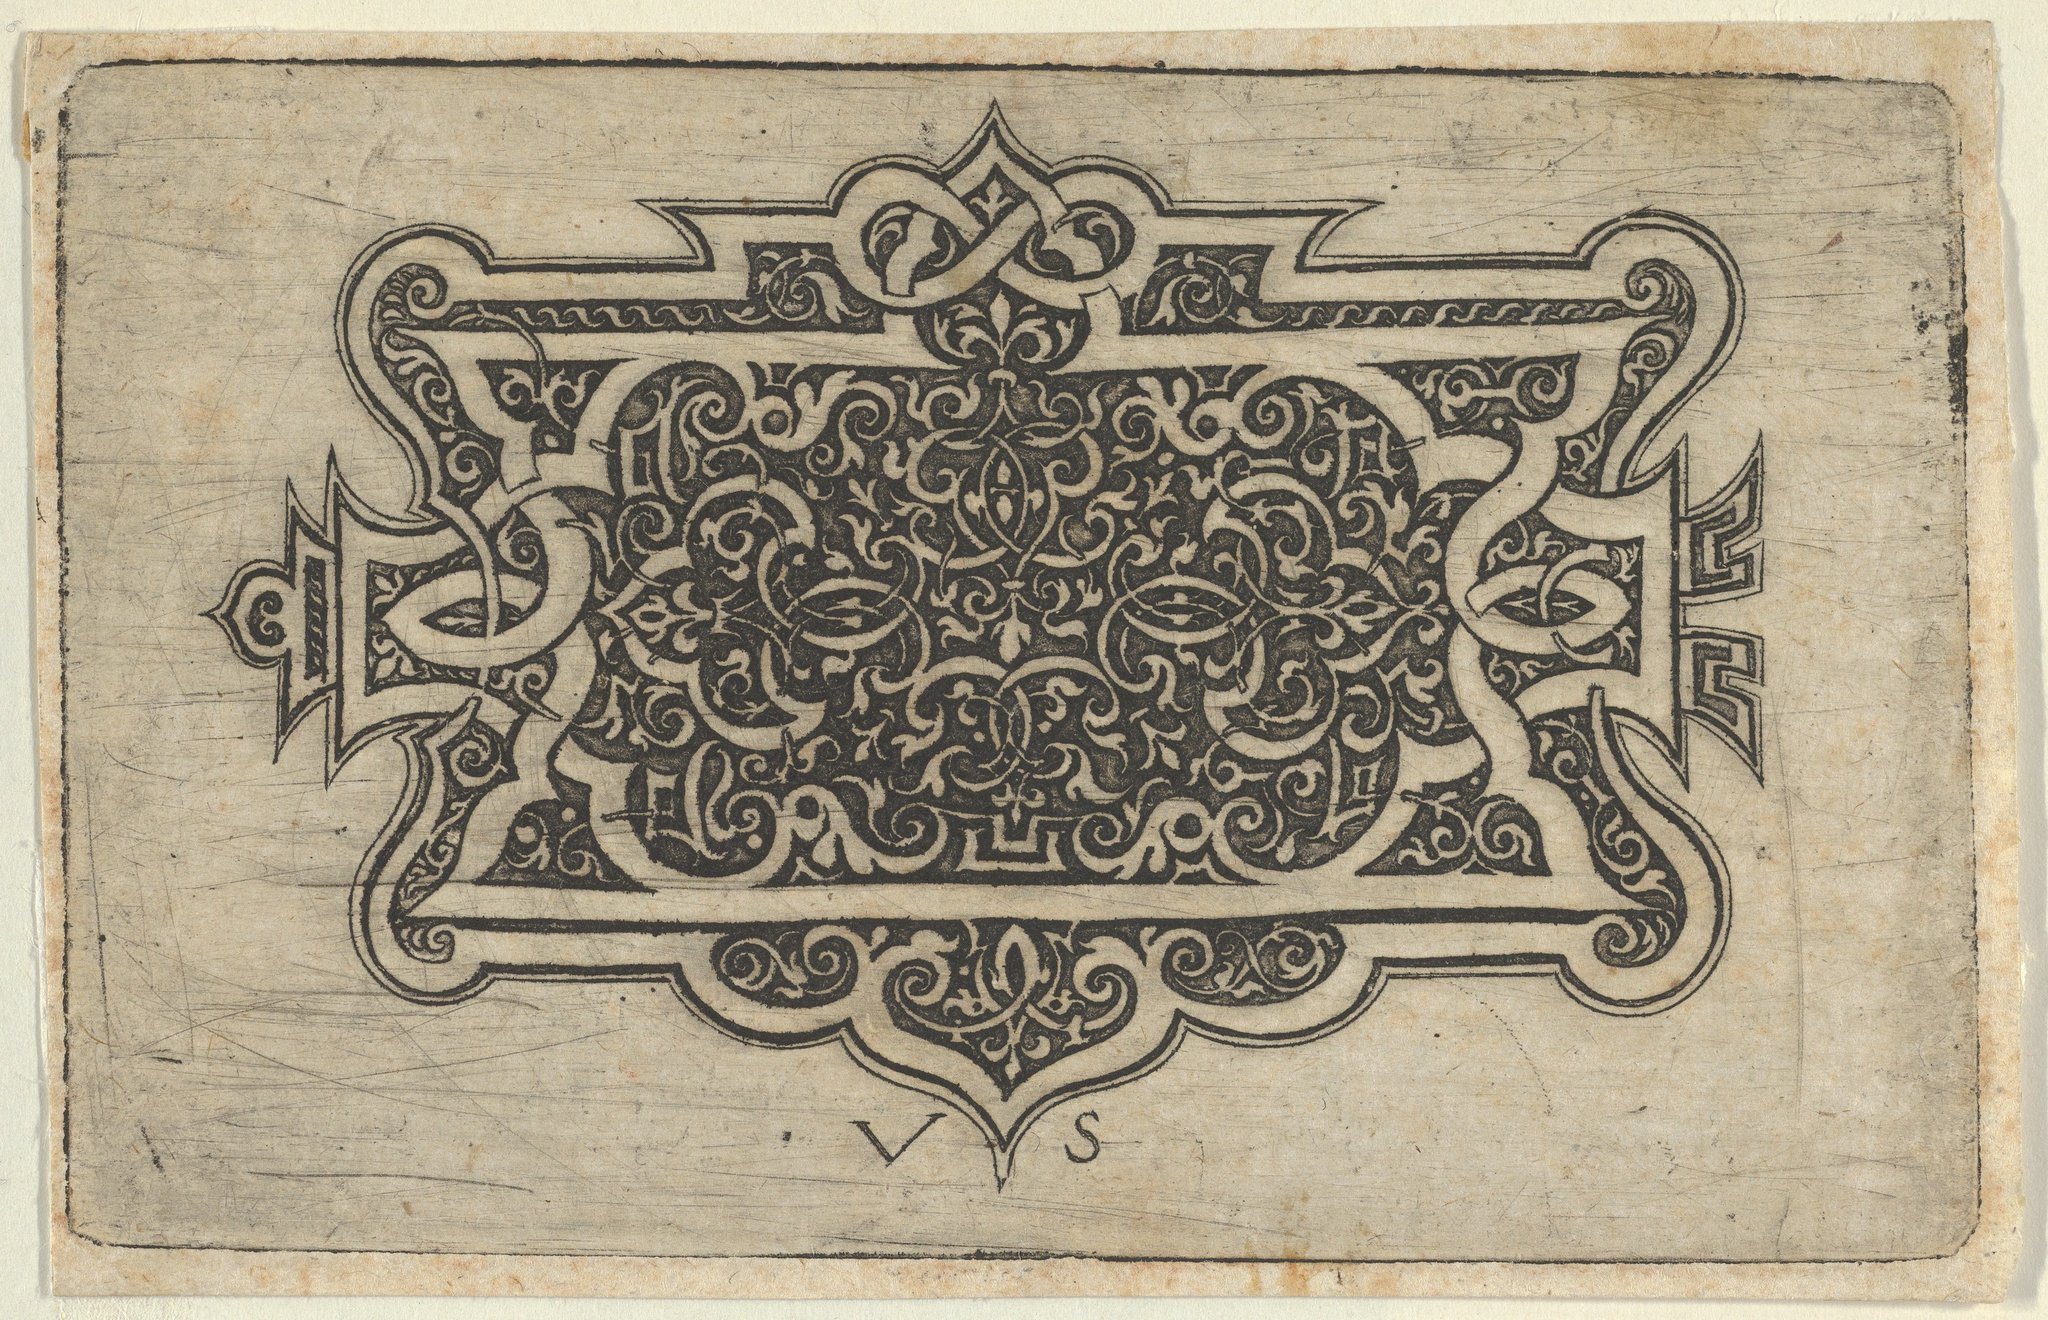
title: Arabesque Design on Dark Ground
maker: virgil solis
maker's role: artist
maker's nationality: german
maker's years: 1514-1562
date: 1534-1562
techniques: engraving, etching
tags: ornament